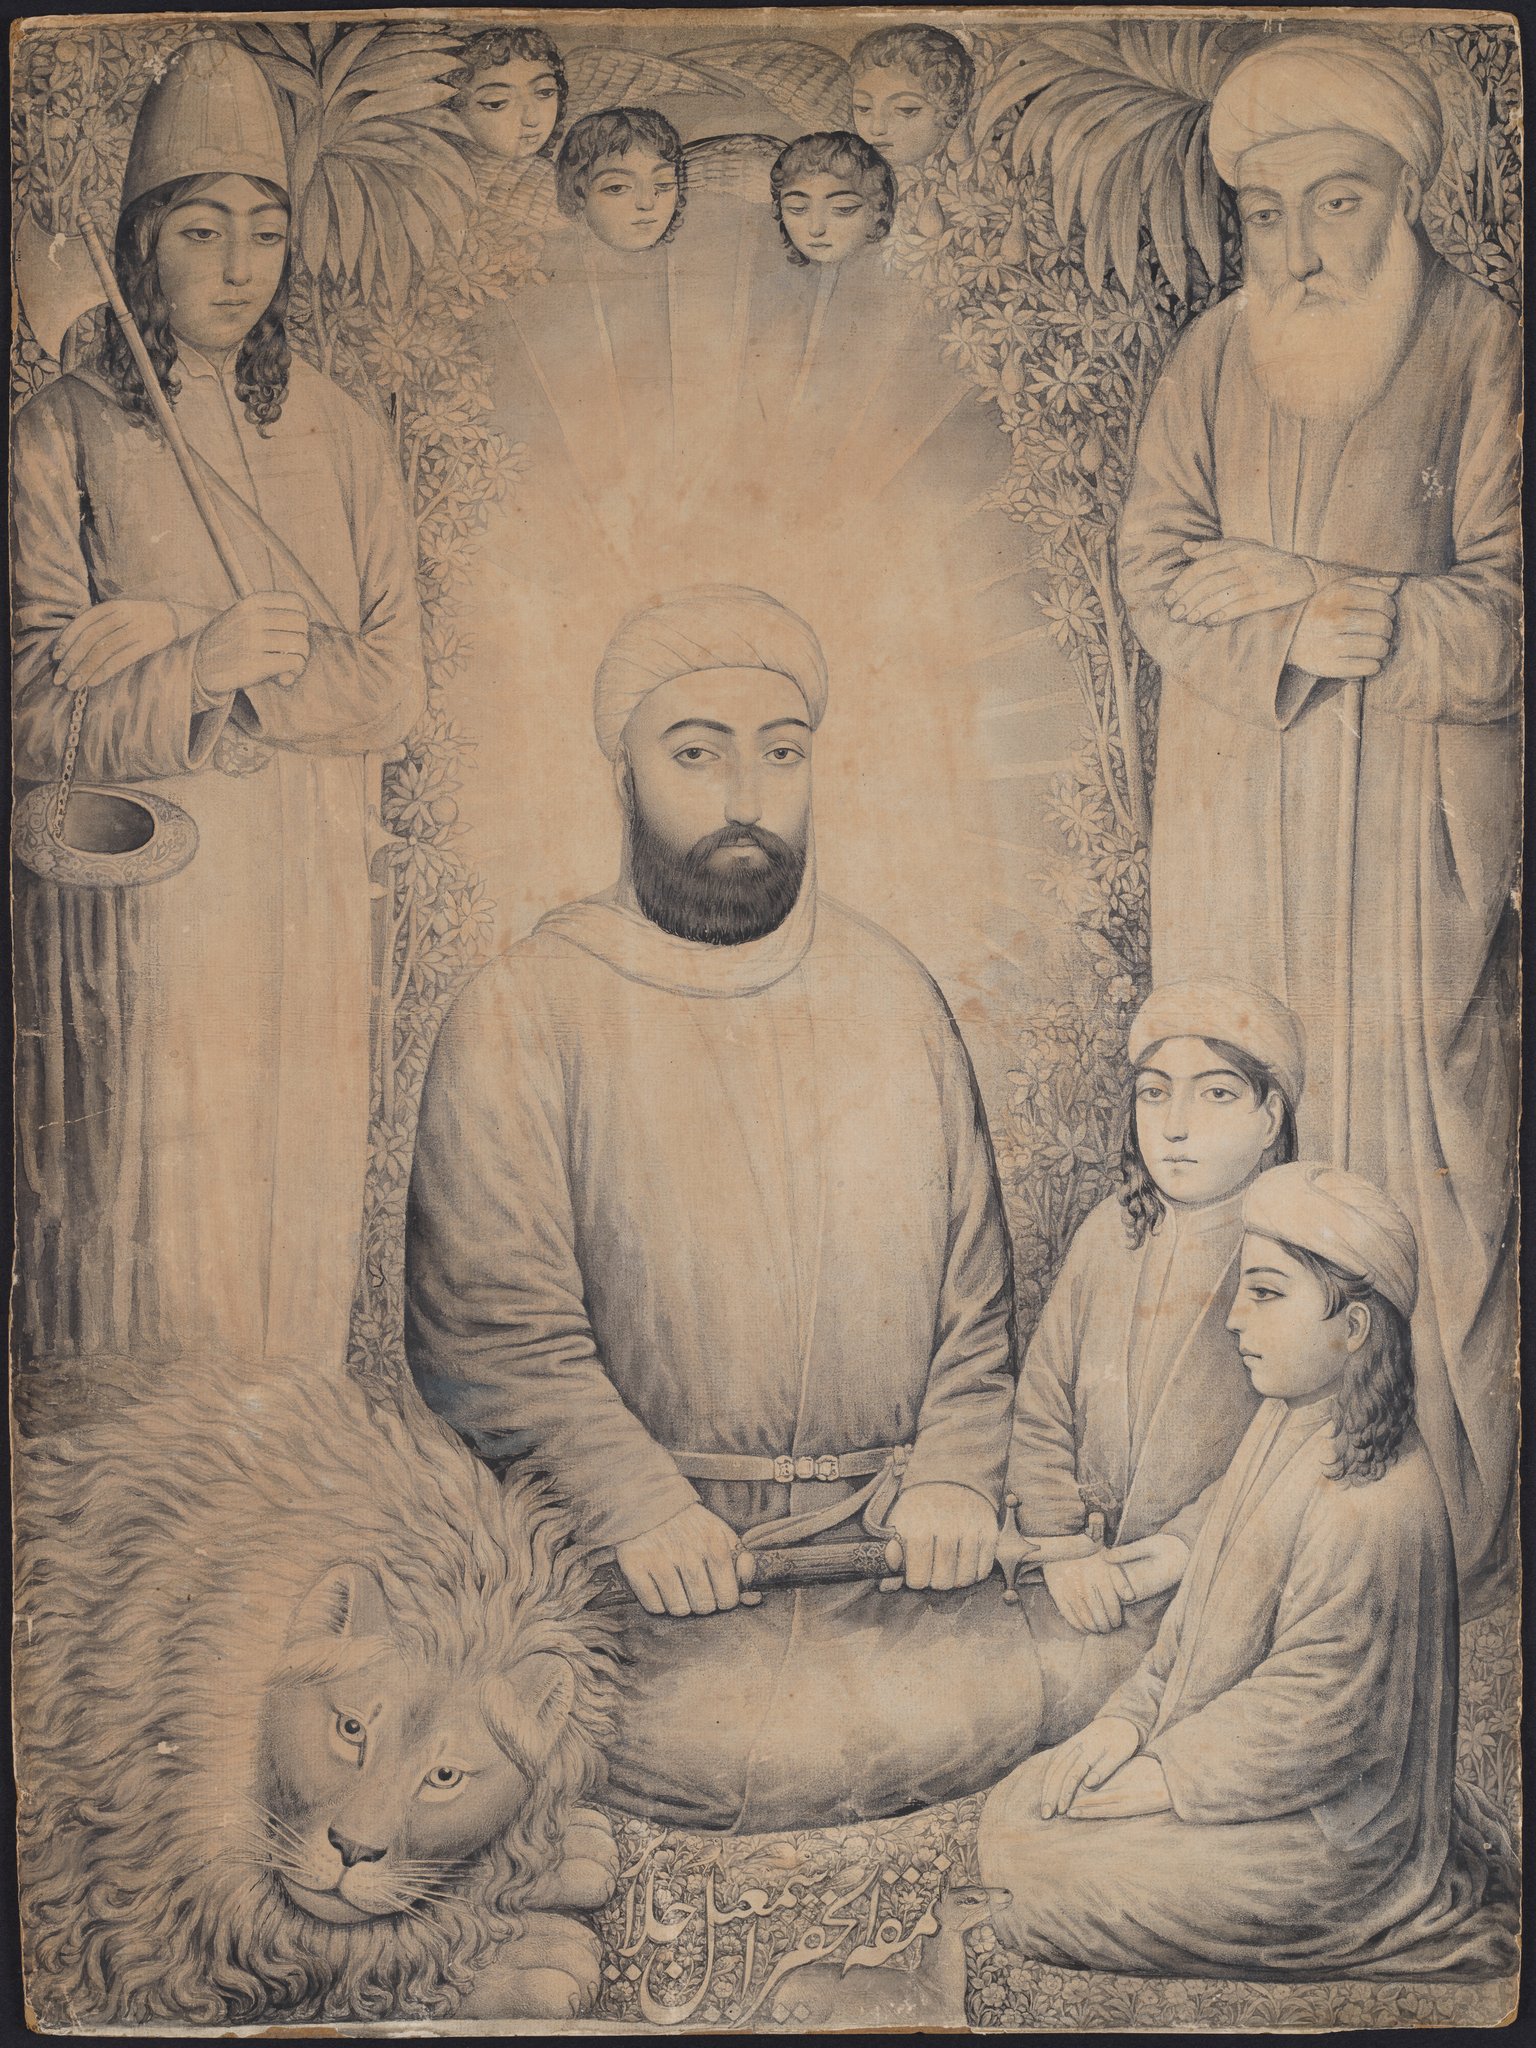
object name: illustrated single work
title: Imam 'Ali and Sons with a Lion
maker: isma'il jalayir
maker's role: artist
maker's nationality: iranian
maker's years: 1785-1899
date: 1860-1869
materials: cardboard, ink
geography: iran